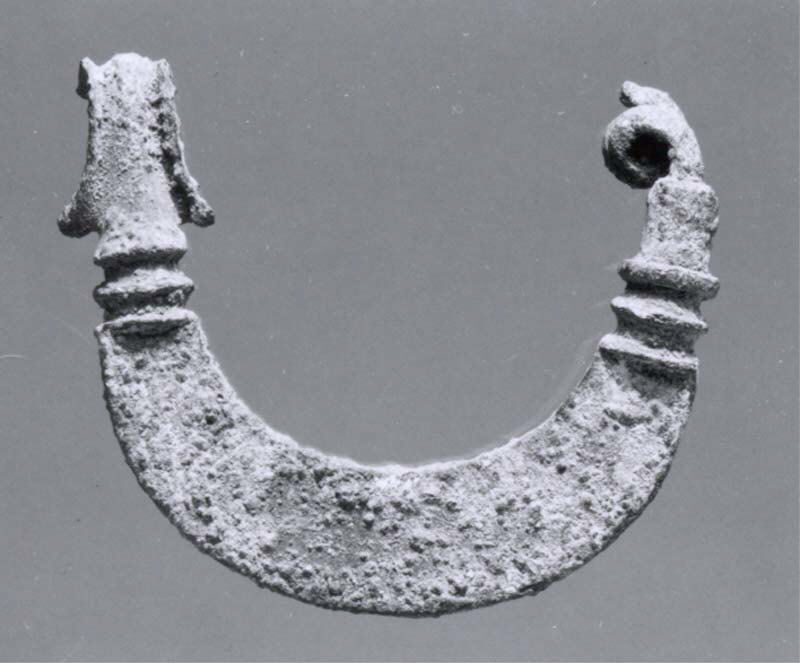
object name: fibula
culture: phrygian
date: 800-601 BCE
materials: bronze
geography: phrygia